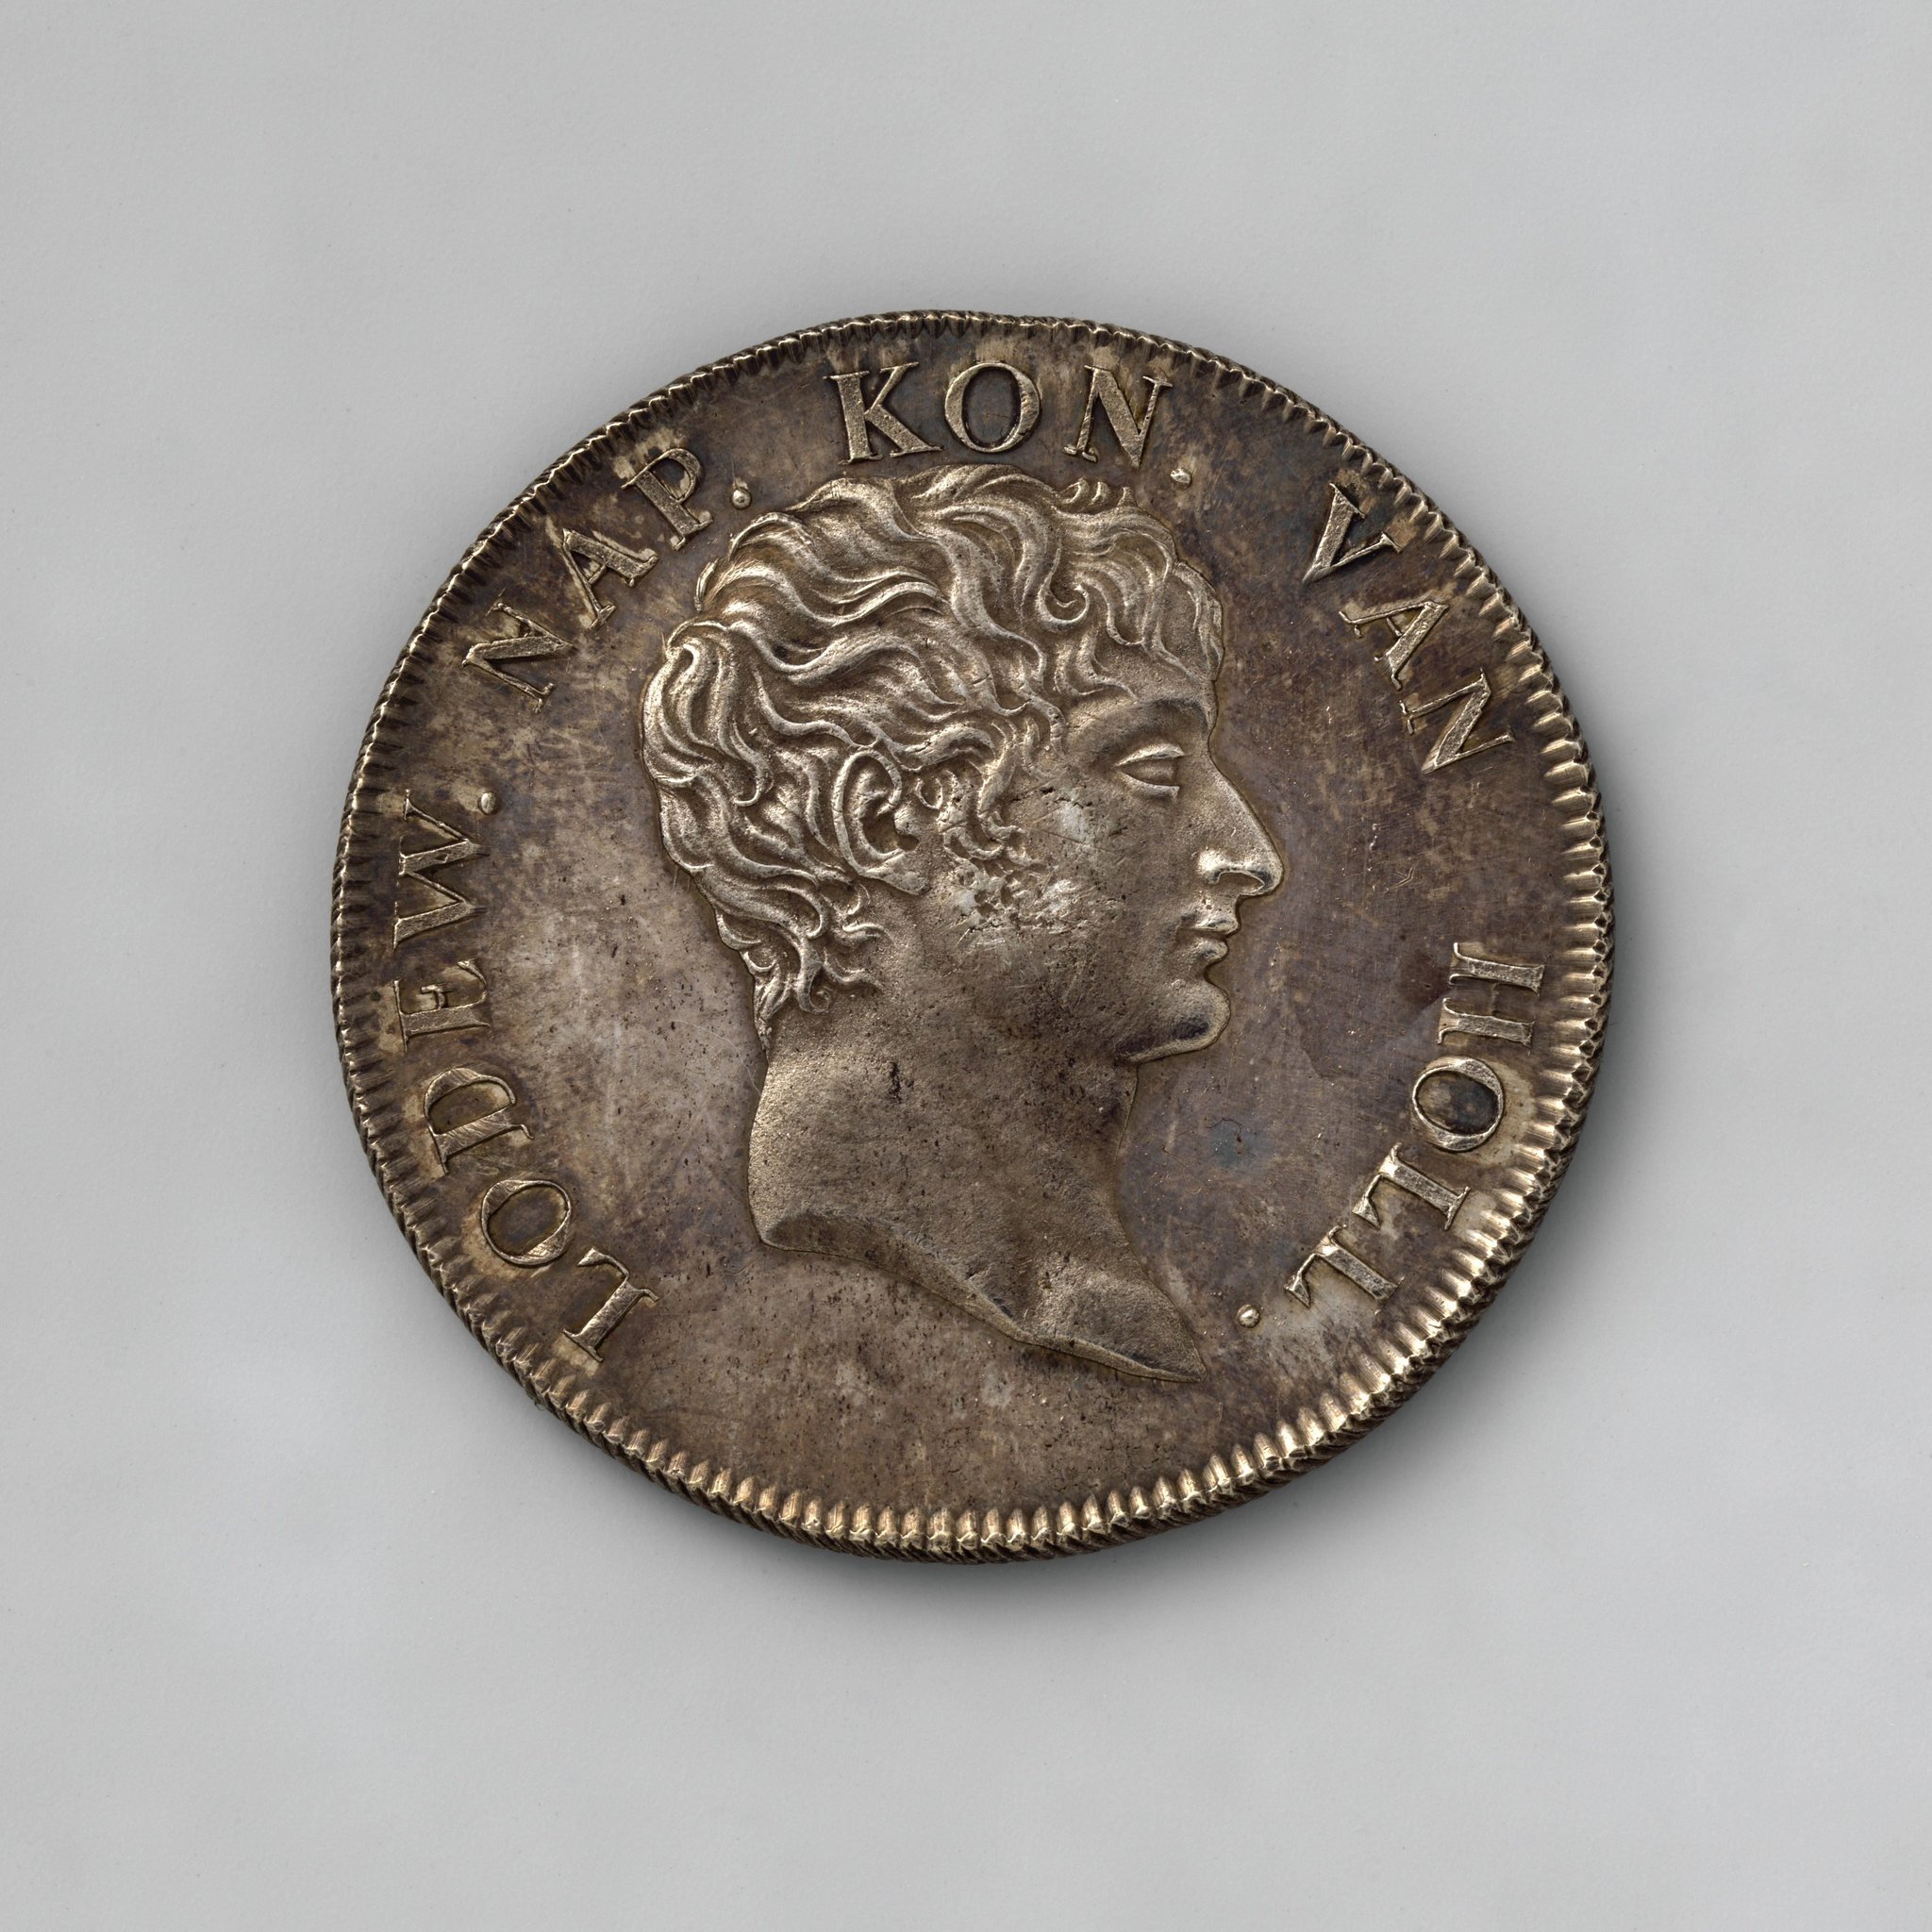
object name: reichsthaler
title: Koninkrijk Holland, rijksdaalder, 1809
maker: louis napoleon (king of holland)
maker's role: koning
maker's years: 1778-1846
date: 1809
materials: silver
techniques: striking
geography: utrecht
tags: louis napoleon (king of holland), netherlands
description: Zilveren munt. Voorzijde: borstbeeld van de koning naar rechts. Keerzijde: tussen naams-aanduiding R Dr gekroond wapenschild, waaronder jaartal. Daaronder muntmeesterteken bij. Kabelrand. Zogenaamde negotiepenning.